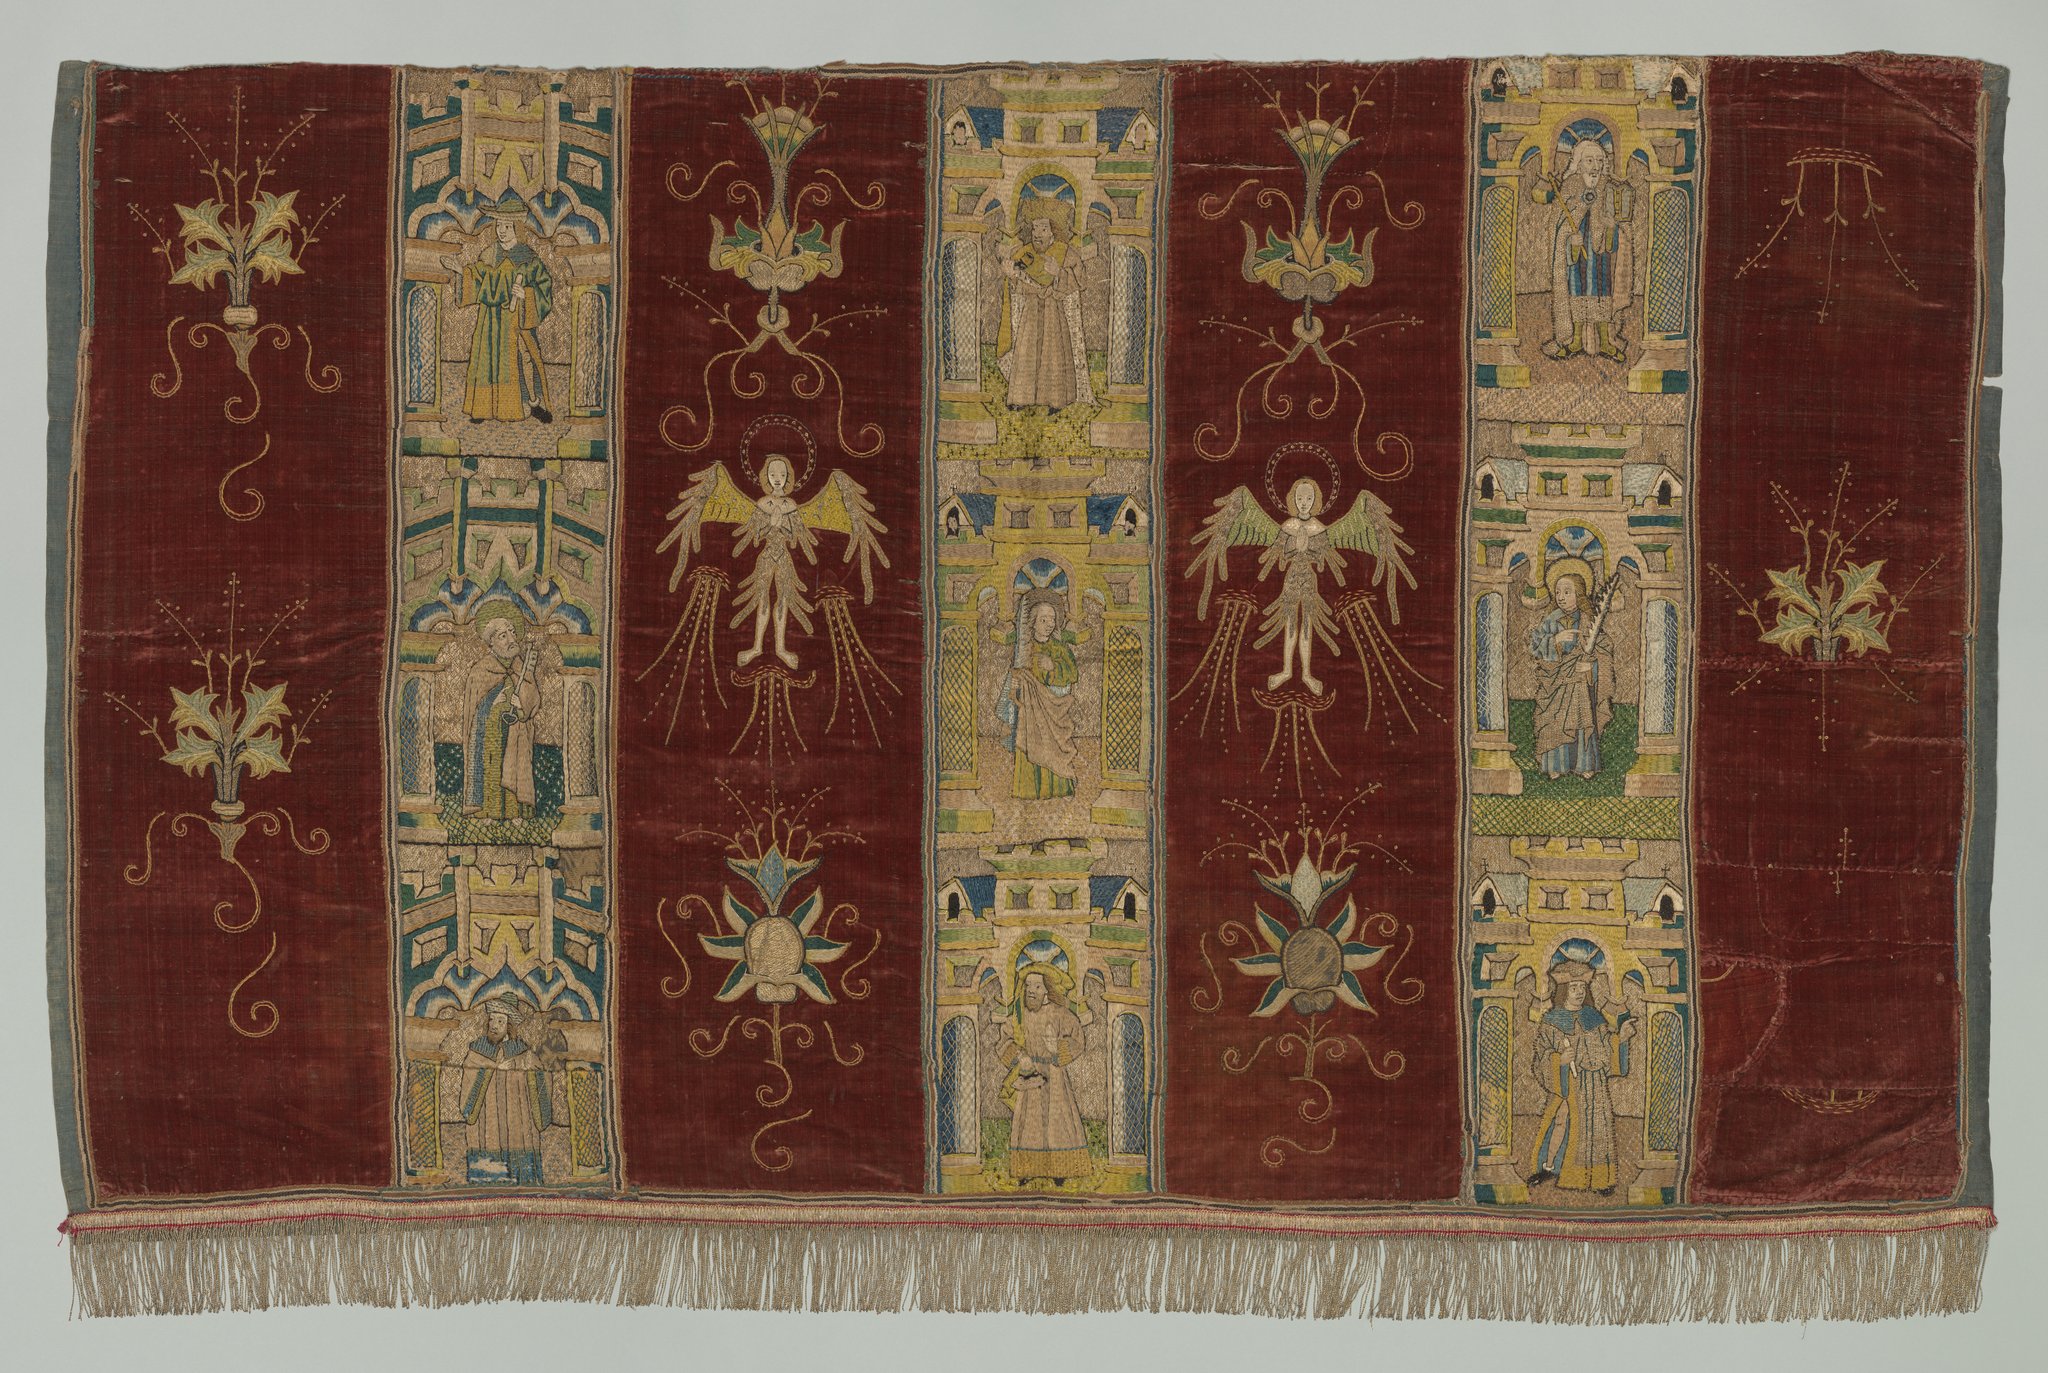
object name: textile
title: Altar Frontal Textile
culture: british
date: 1401-1600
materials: metal thread, velvet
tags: flowers